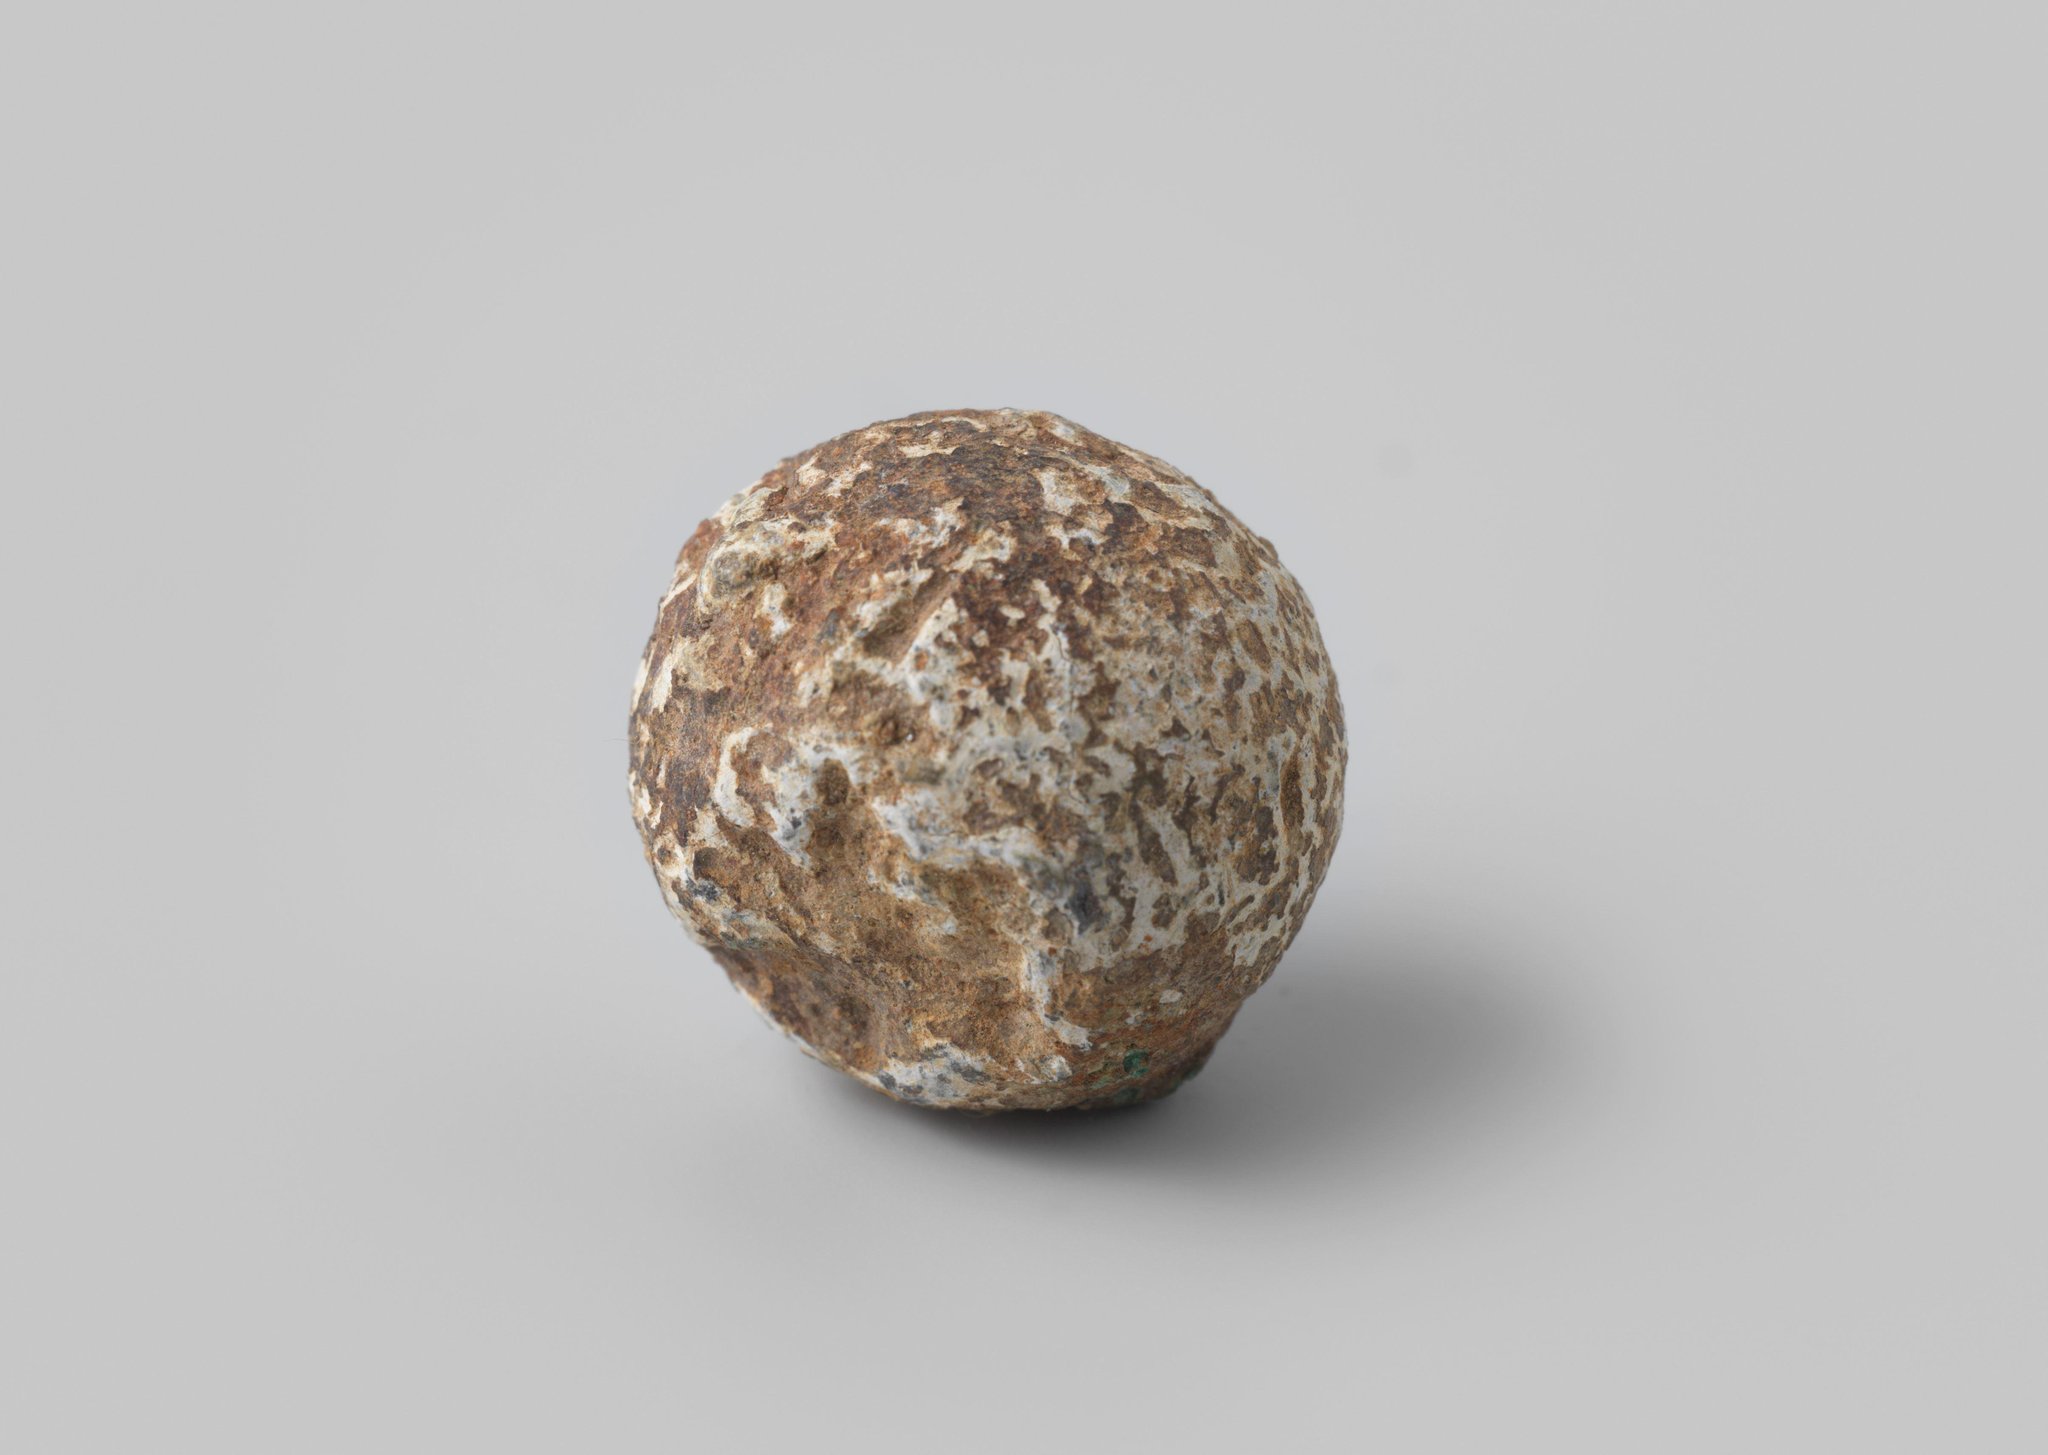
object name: musketkogel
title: Musketkogel uit het wrak van de Oost-Indiëvaarder Hollandia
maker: Anonymous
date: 1700-1743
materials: lead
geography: netherlands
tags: verenigde oostindische compagnie, hollandia (schip), annet